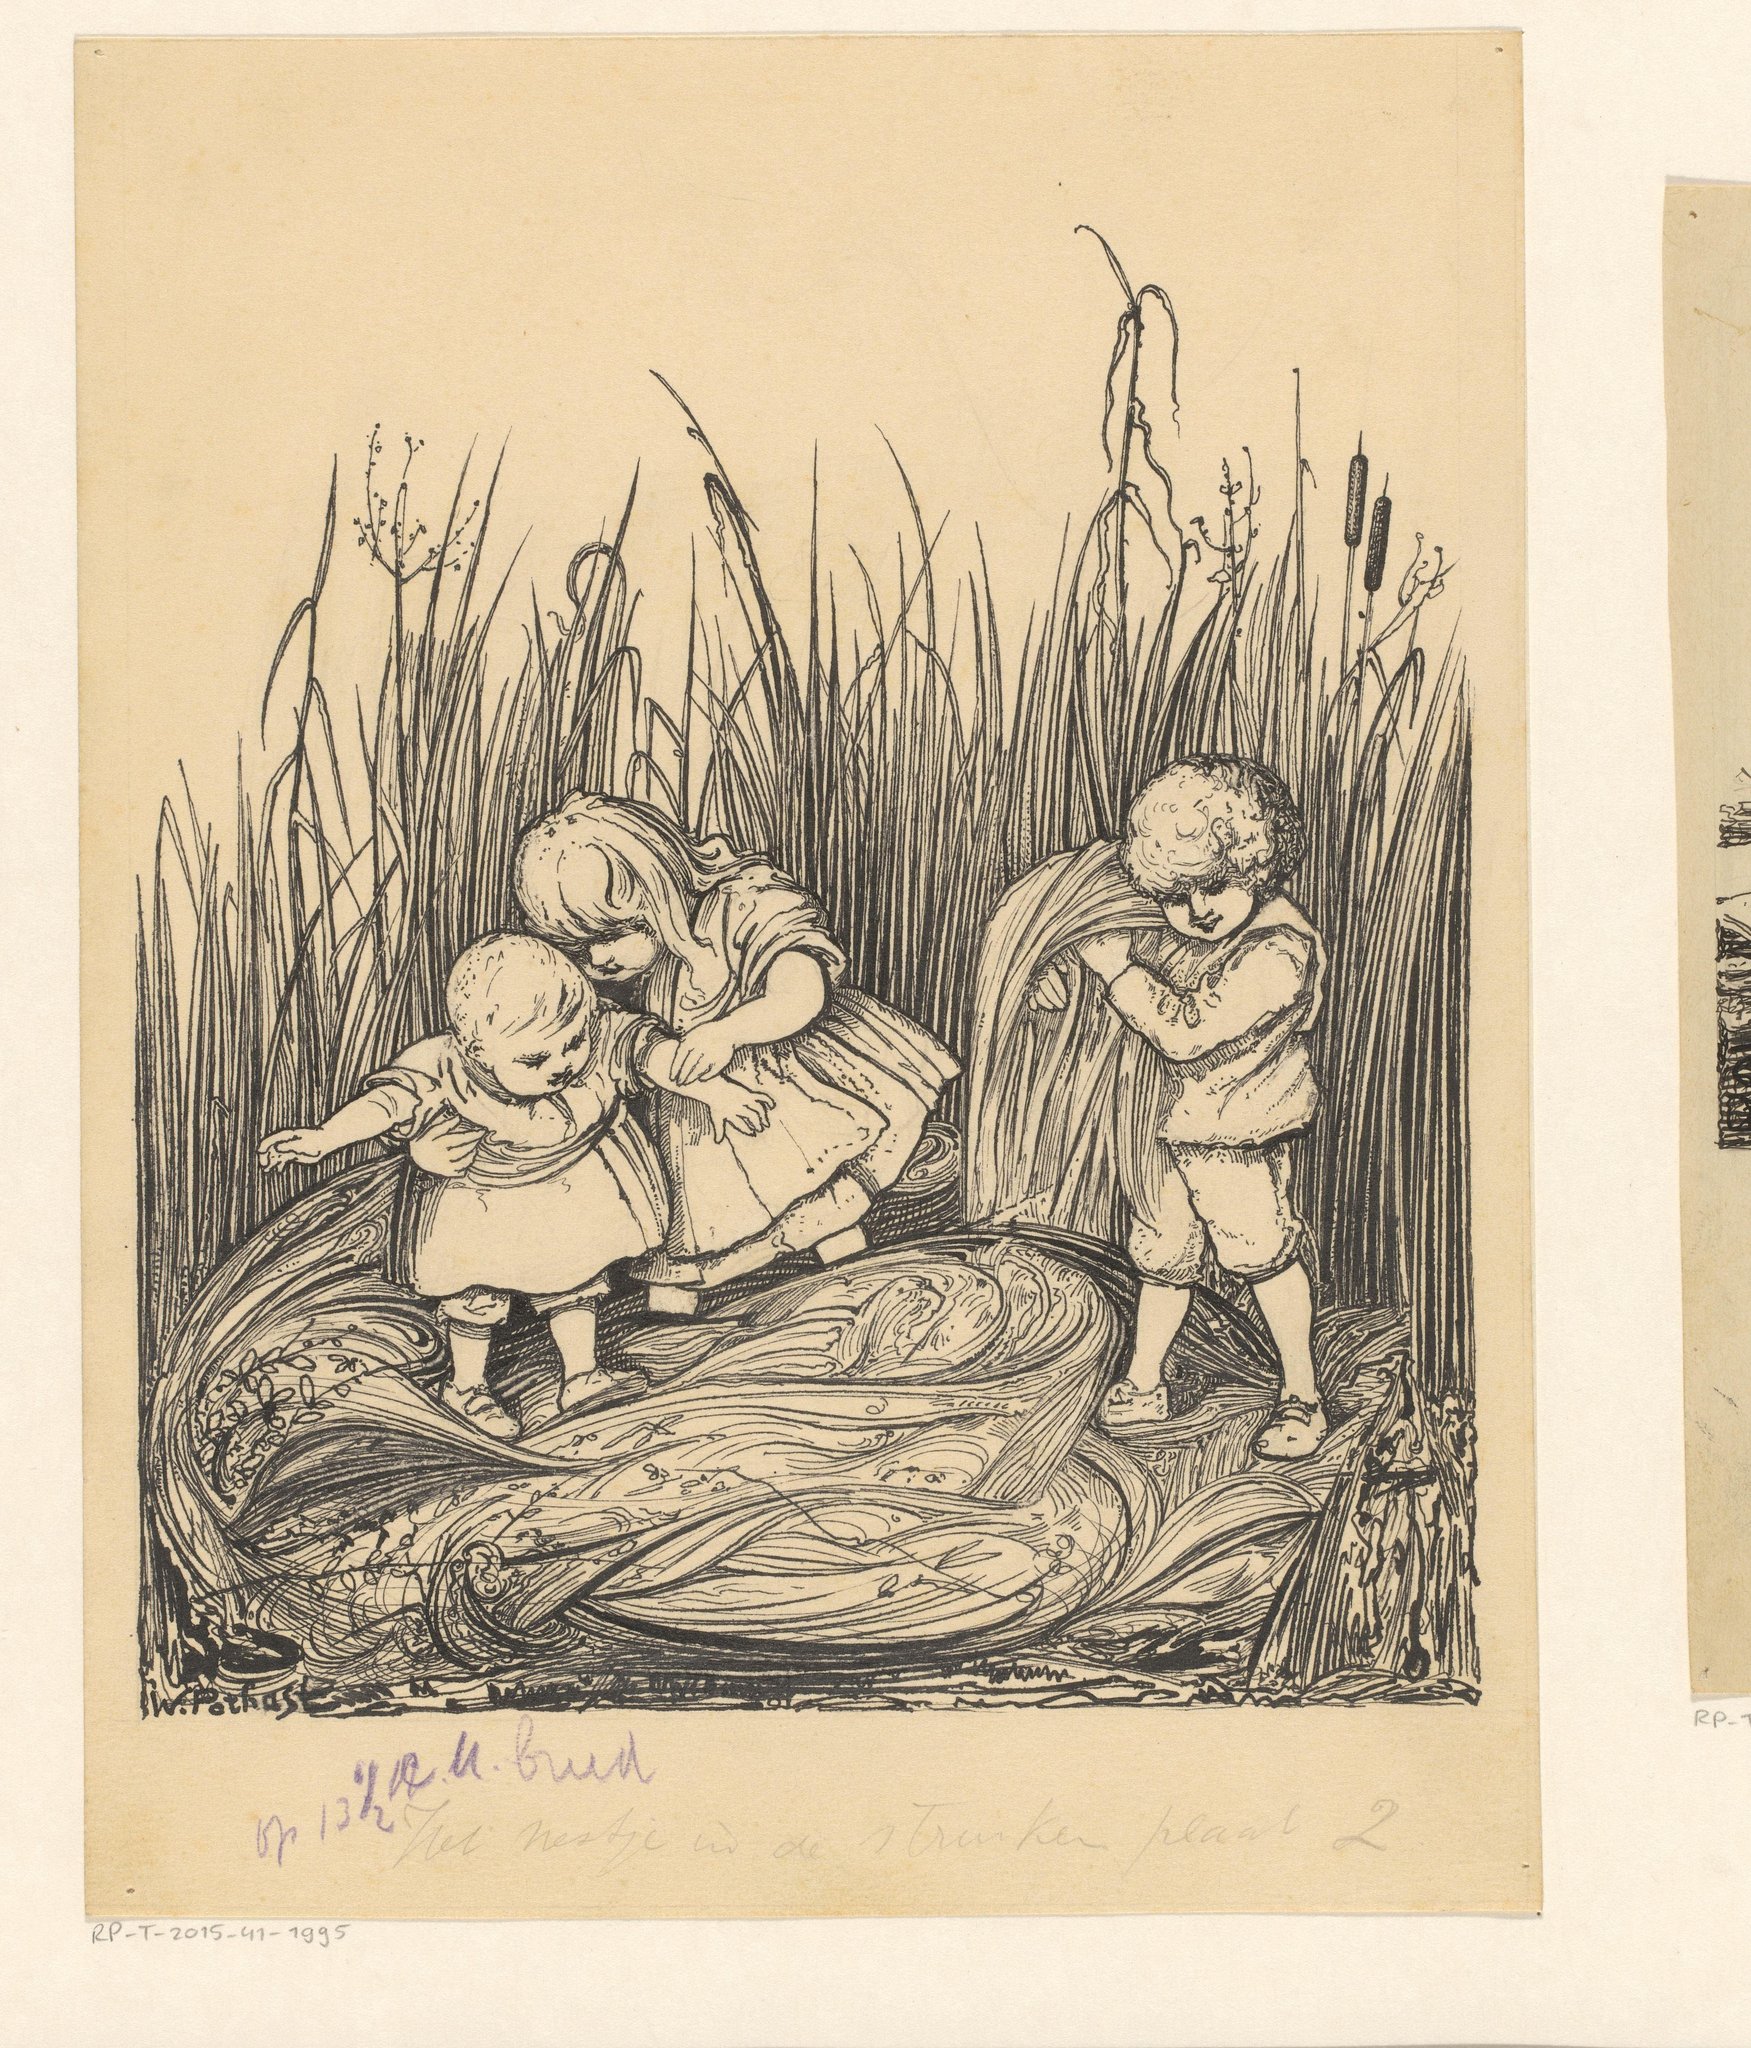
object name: drawing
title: Drie kinderen in het riet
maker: willem pothast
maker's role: draughtsman, print maker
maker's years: 1877-1916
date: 1887-1916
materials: ink, paper, pencil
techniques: pen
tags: boy (child between toddler and youth), girl (child between toddler and youth), plants and herbs: reed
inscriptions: signature: ‘W. Pothast’, annotation: ‘Het nestje in de struiken plaat 2’, :, collector's mark: Lugt 2228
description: Een jongen, meisje en baby staan in het riet, vermoedelijk aan een waterkant. Het meisje ondersteunt de baby.